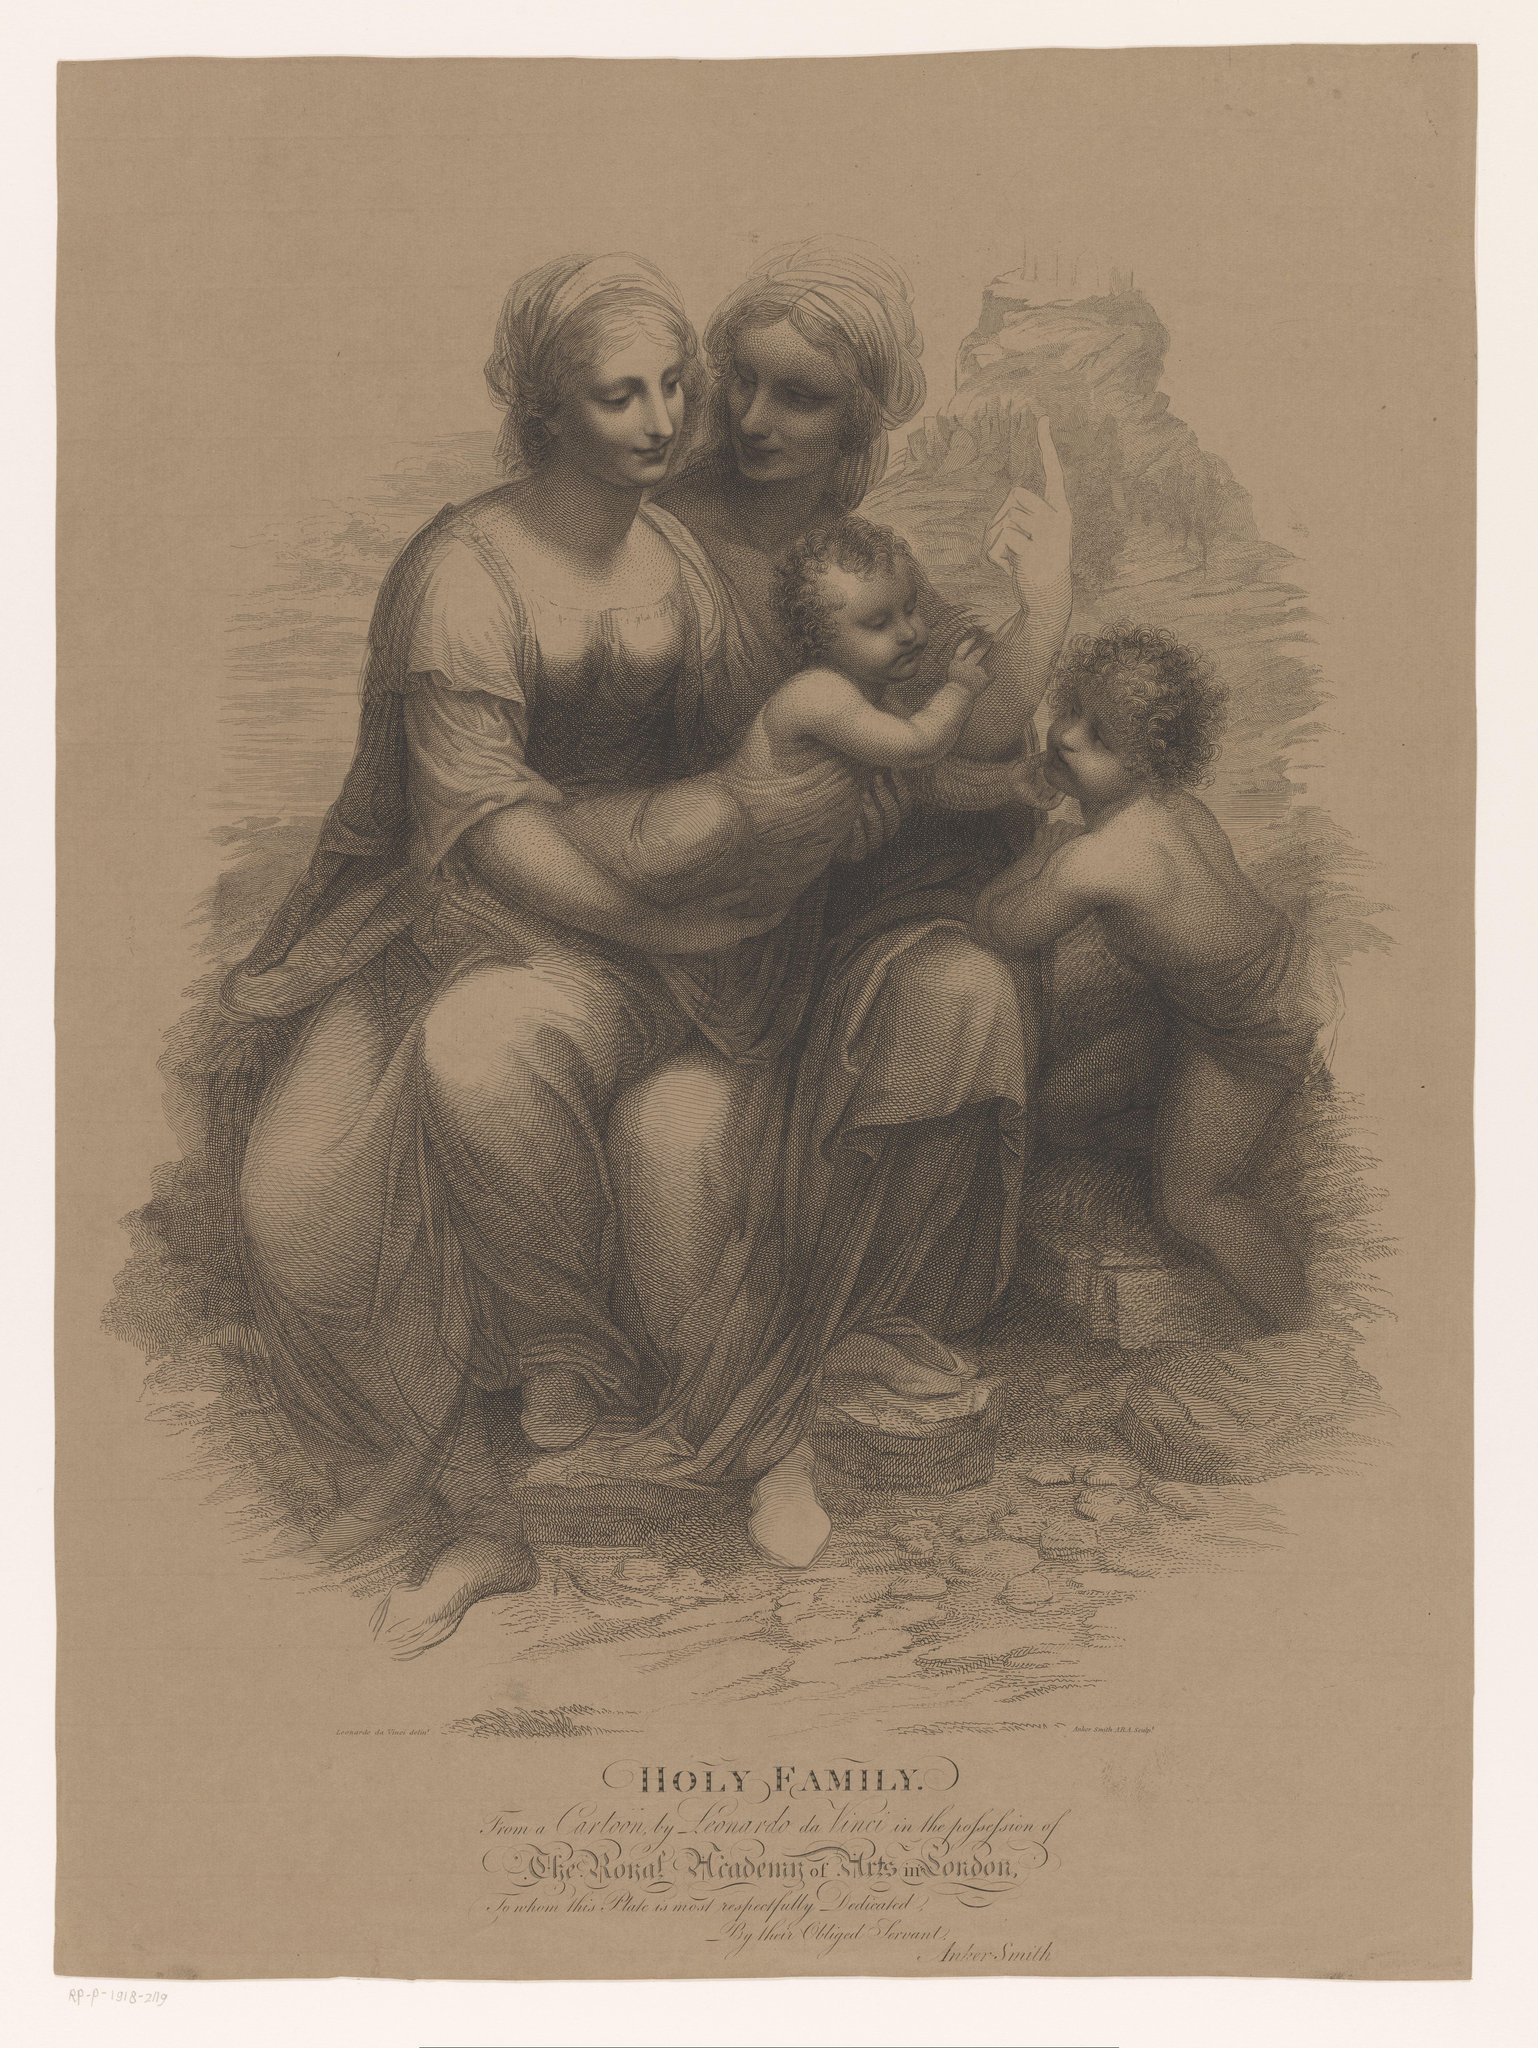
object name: print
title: Holy Family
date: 1769-1798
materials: paper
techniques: engraving, etching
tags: holy family with john the baptist, elisabeth present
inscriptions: collector's mark: Lugt 2233